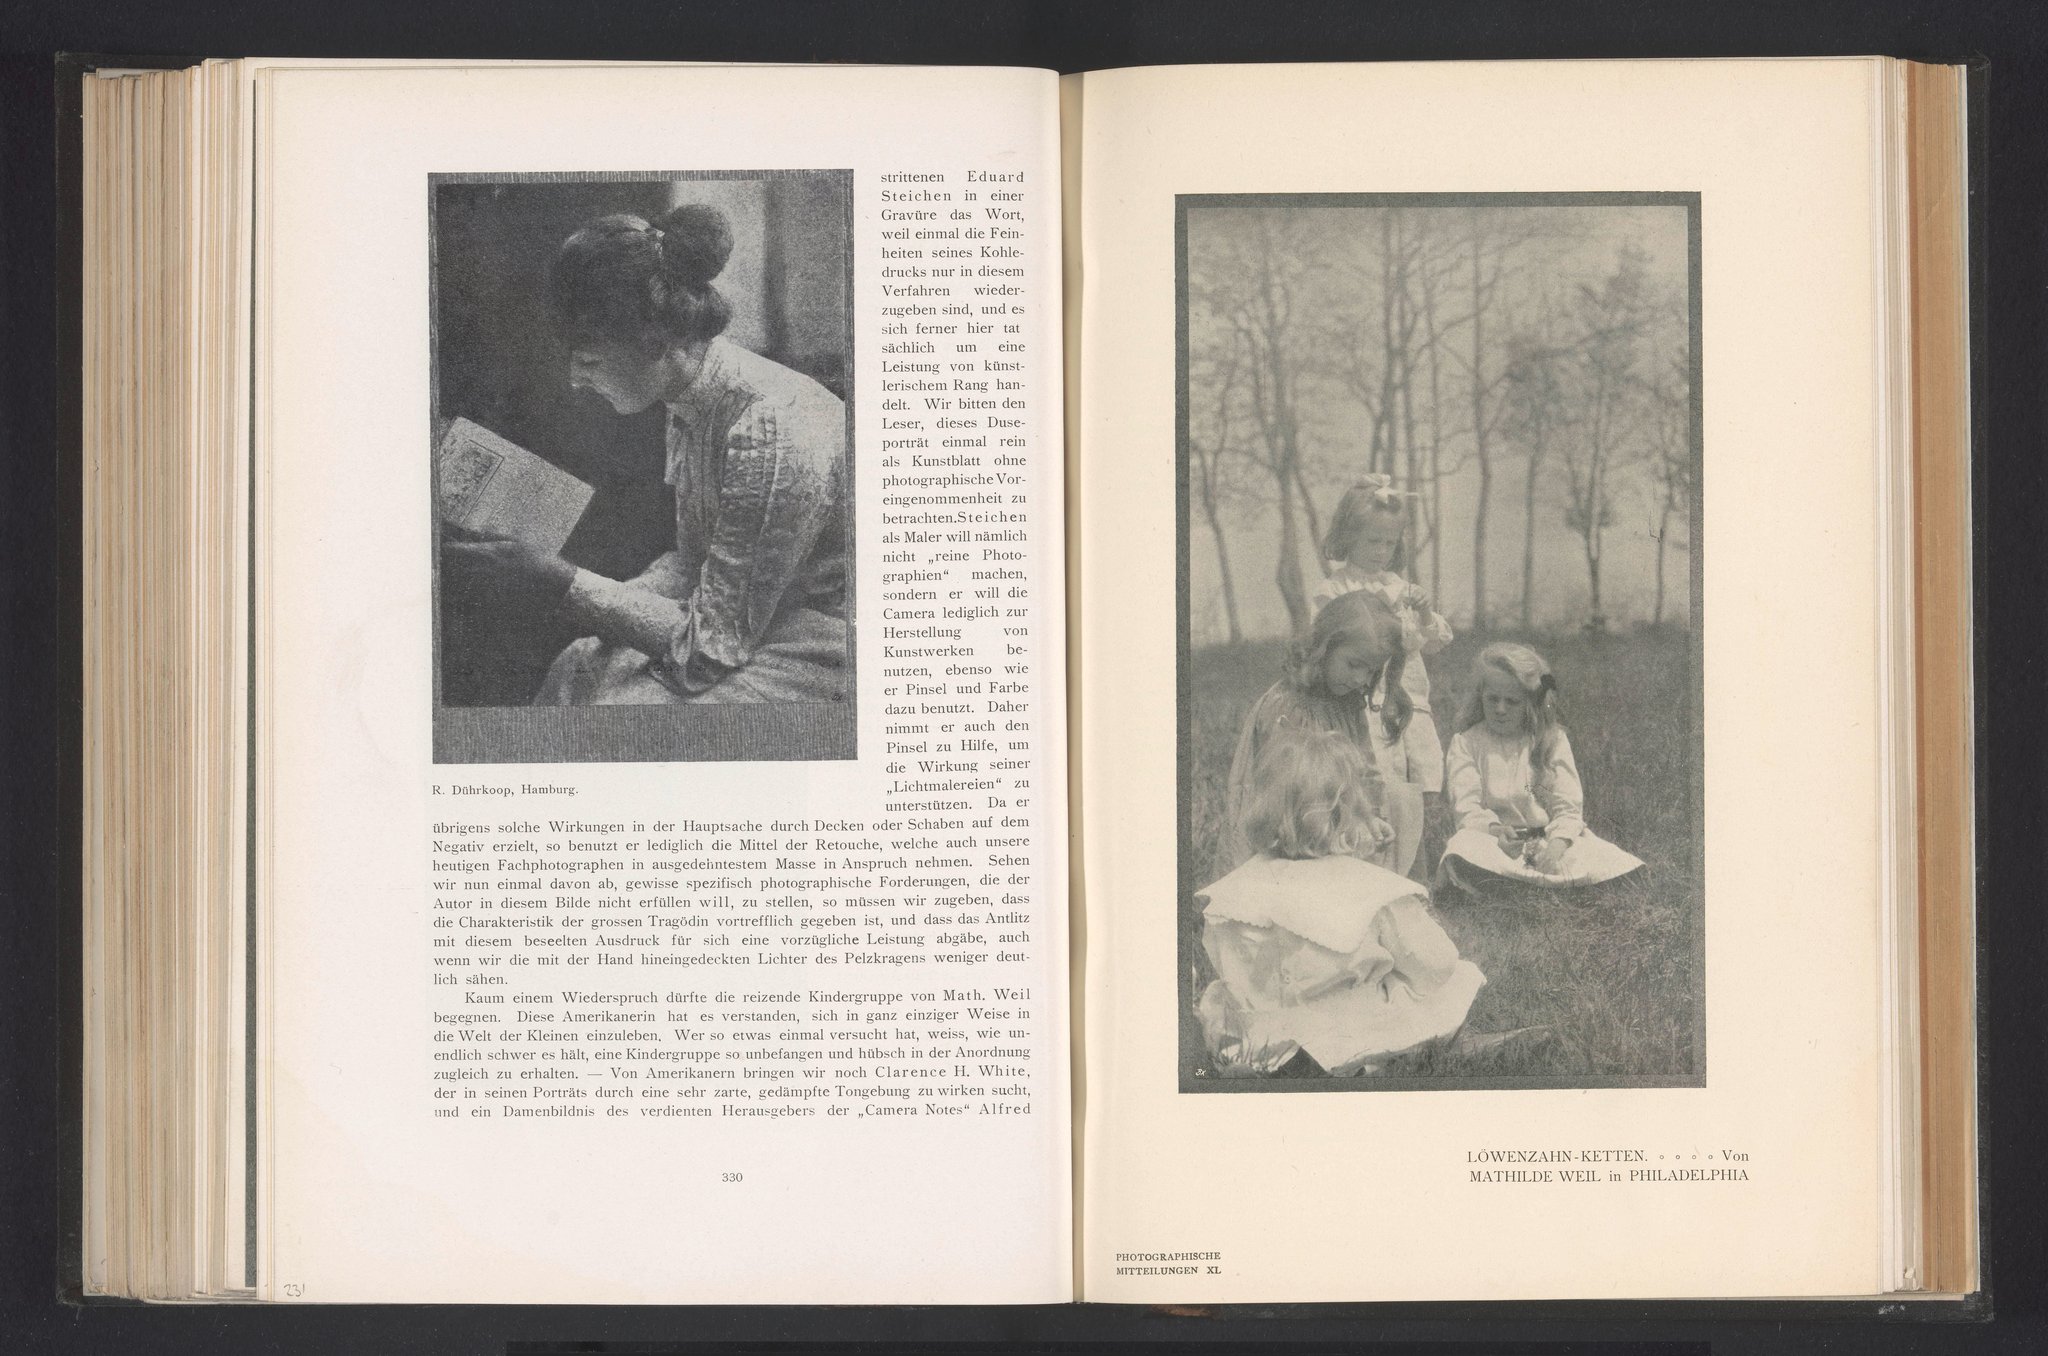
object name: photomechanical print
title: Groepsportret van vier meisjes in het gras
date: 1898-1903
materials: paper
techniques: autotype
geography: philadelphia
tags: child and nature (games and plays), anonymous historical persons portrayed in a group, in a group-portrait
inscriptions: monogram: ‘BX’